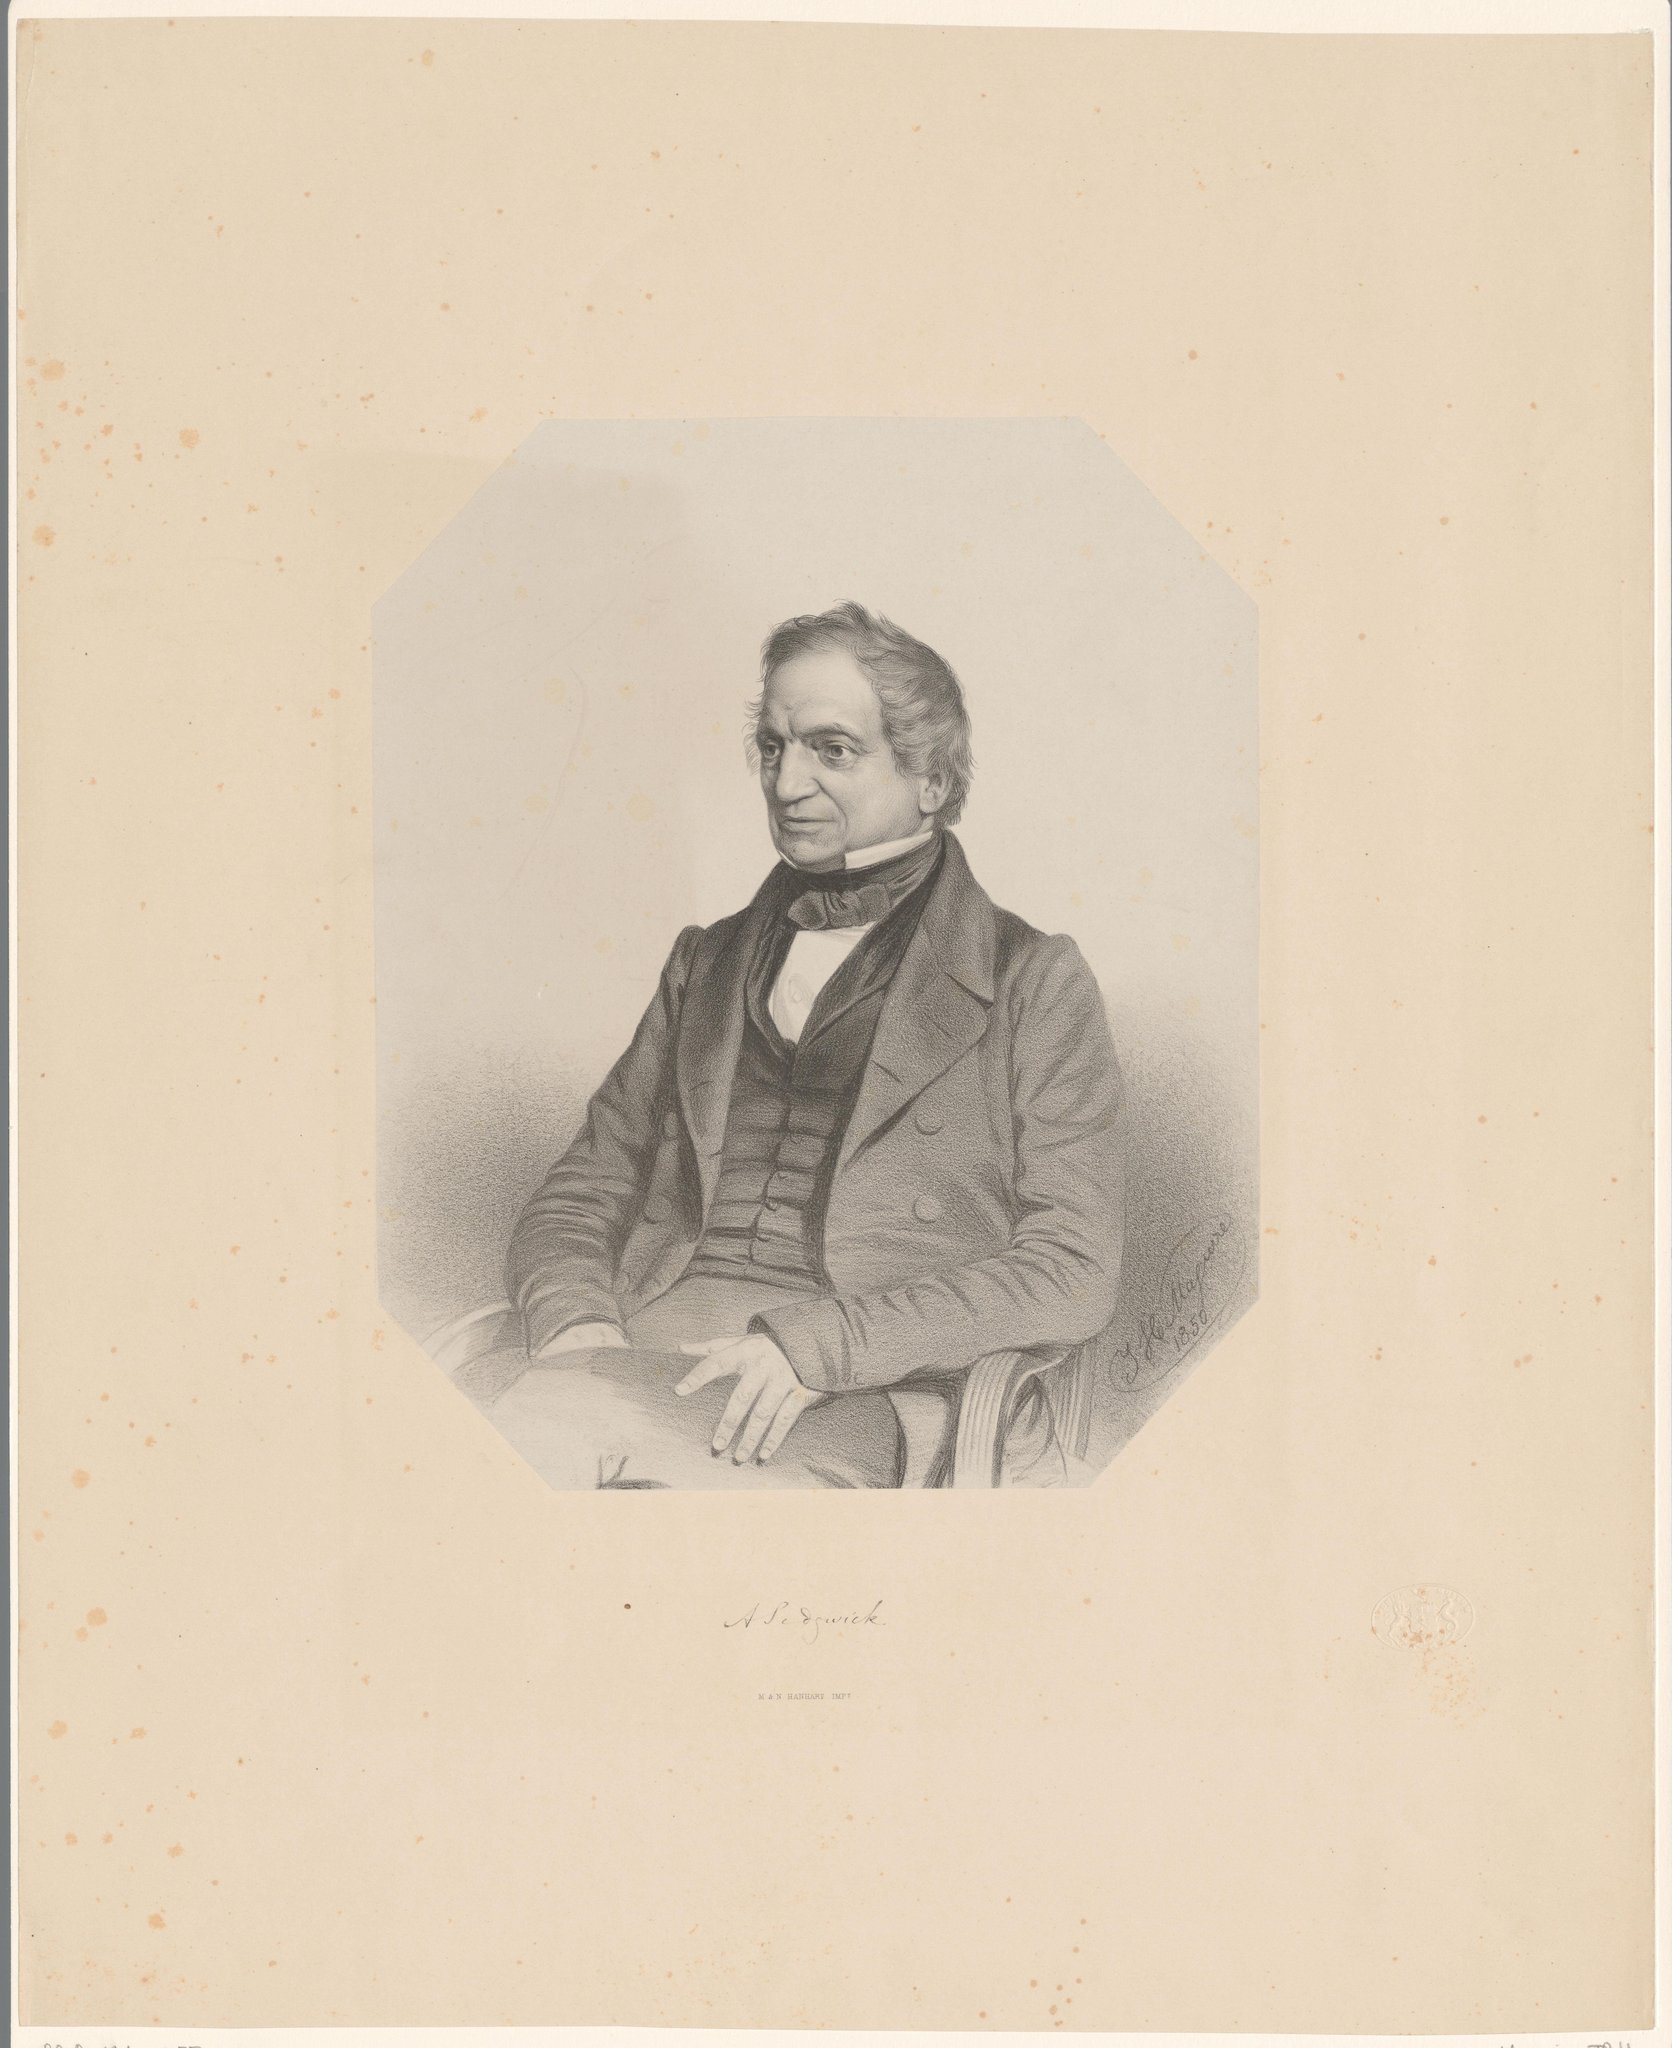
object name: print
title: Portret van Adam Sedgwick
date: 1852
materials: paper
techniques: lithograph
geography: london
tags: adult man, historical persons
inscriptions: collector's mark: Lugt 2228, check stamp: ‘Ipswich Museum’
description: Prent behoort tot de serie 'Ipswich Museum Portraits', ook bekend onder de titel 'Portraits of Honorary Members of the Ipswich Museum'. Deze serie is in 1852 door George Ransome uitgegeven en gedrukt door M&N Hanhart tussen 1848 en 1852. De serie bestaat uit ca. 60 portretten.